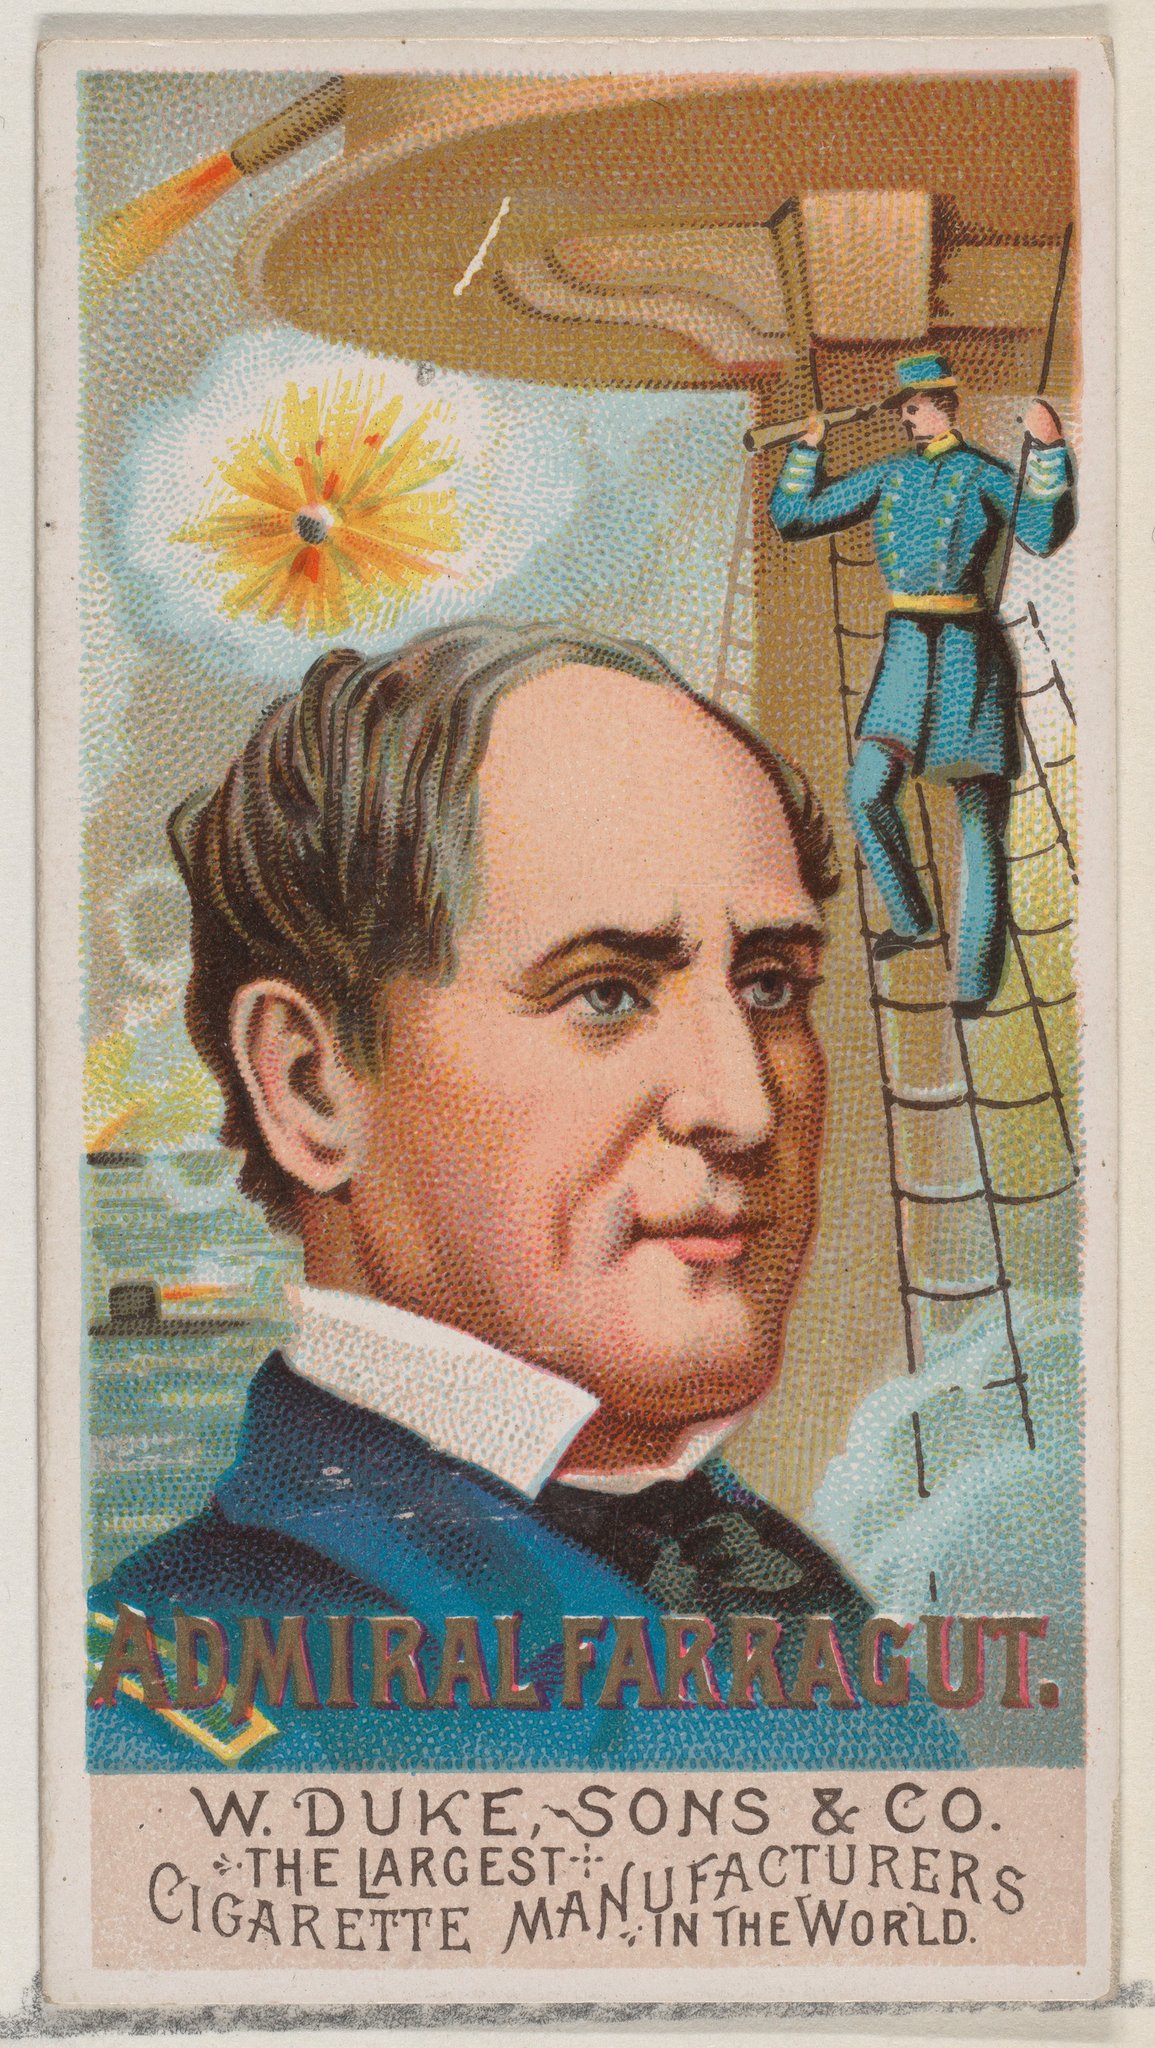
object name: print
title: Admiral Farragut, from the series Great Americans (N76) for Duke brand cigarettes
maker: w. duke, sons & co.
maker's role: publisher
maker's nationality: american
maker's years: 1870-1920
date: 1888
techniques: color lithograph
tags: men